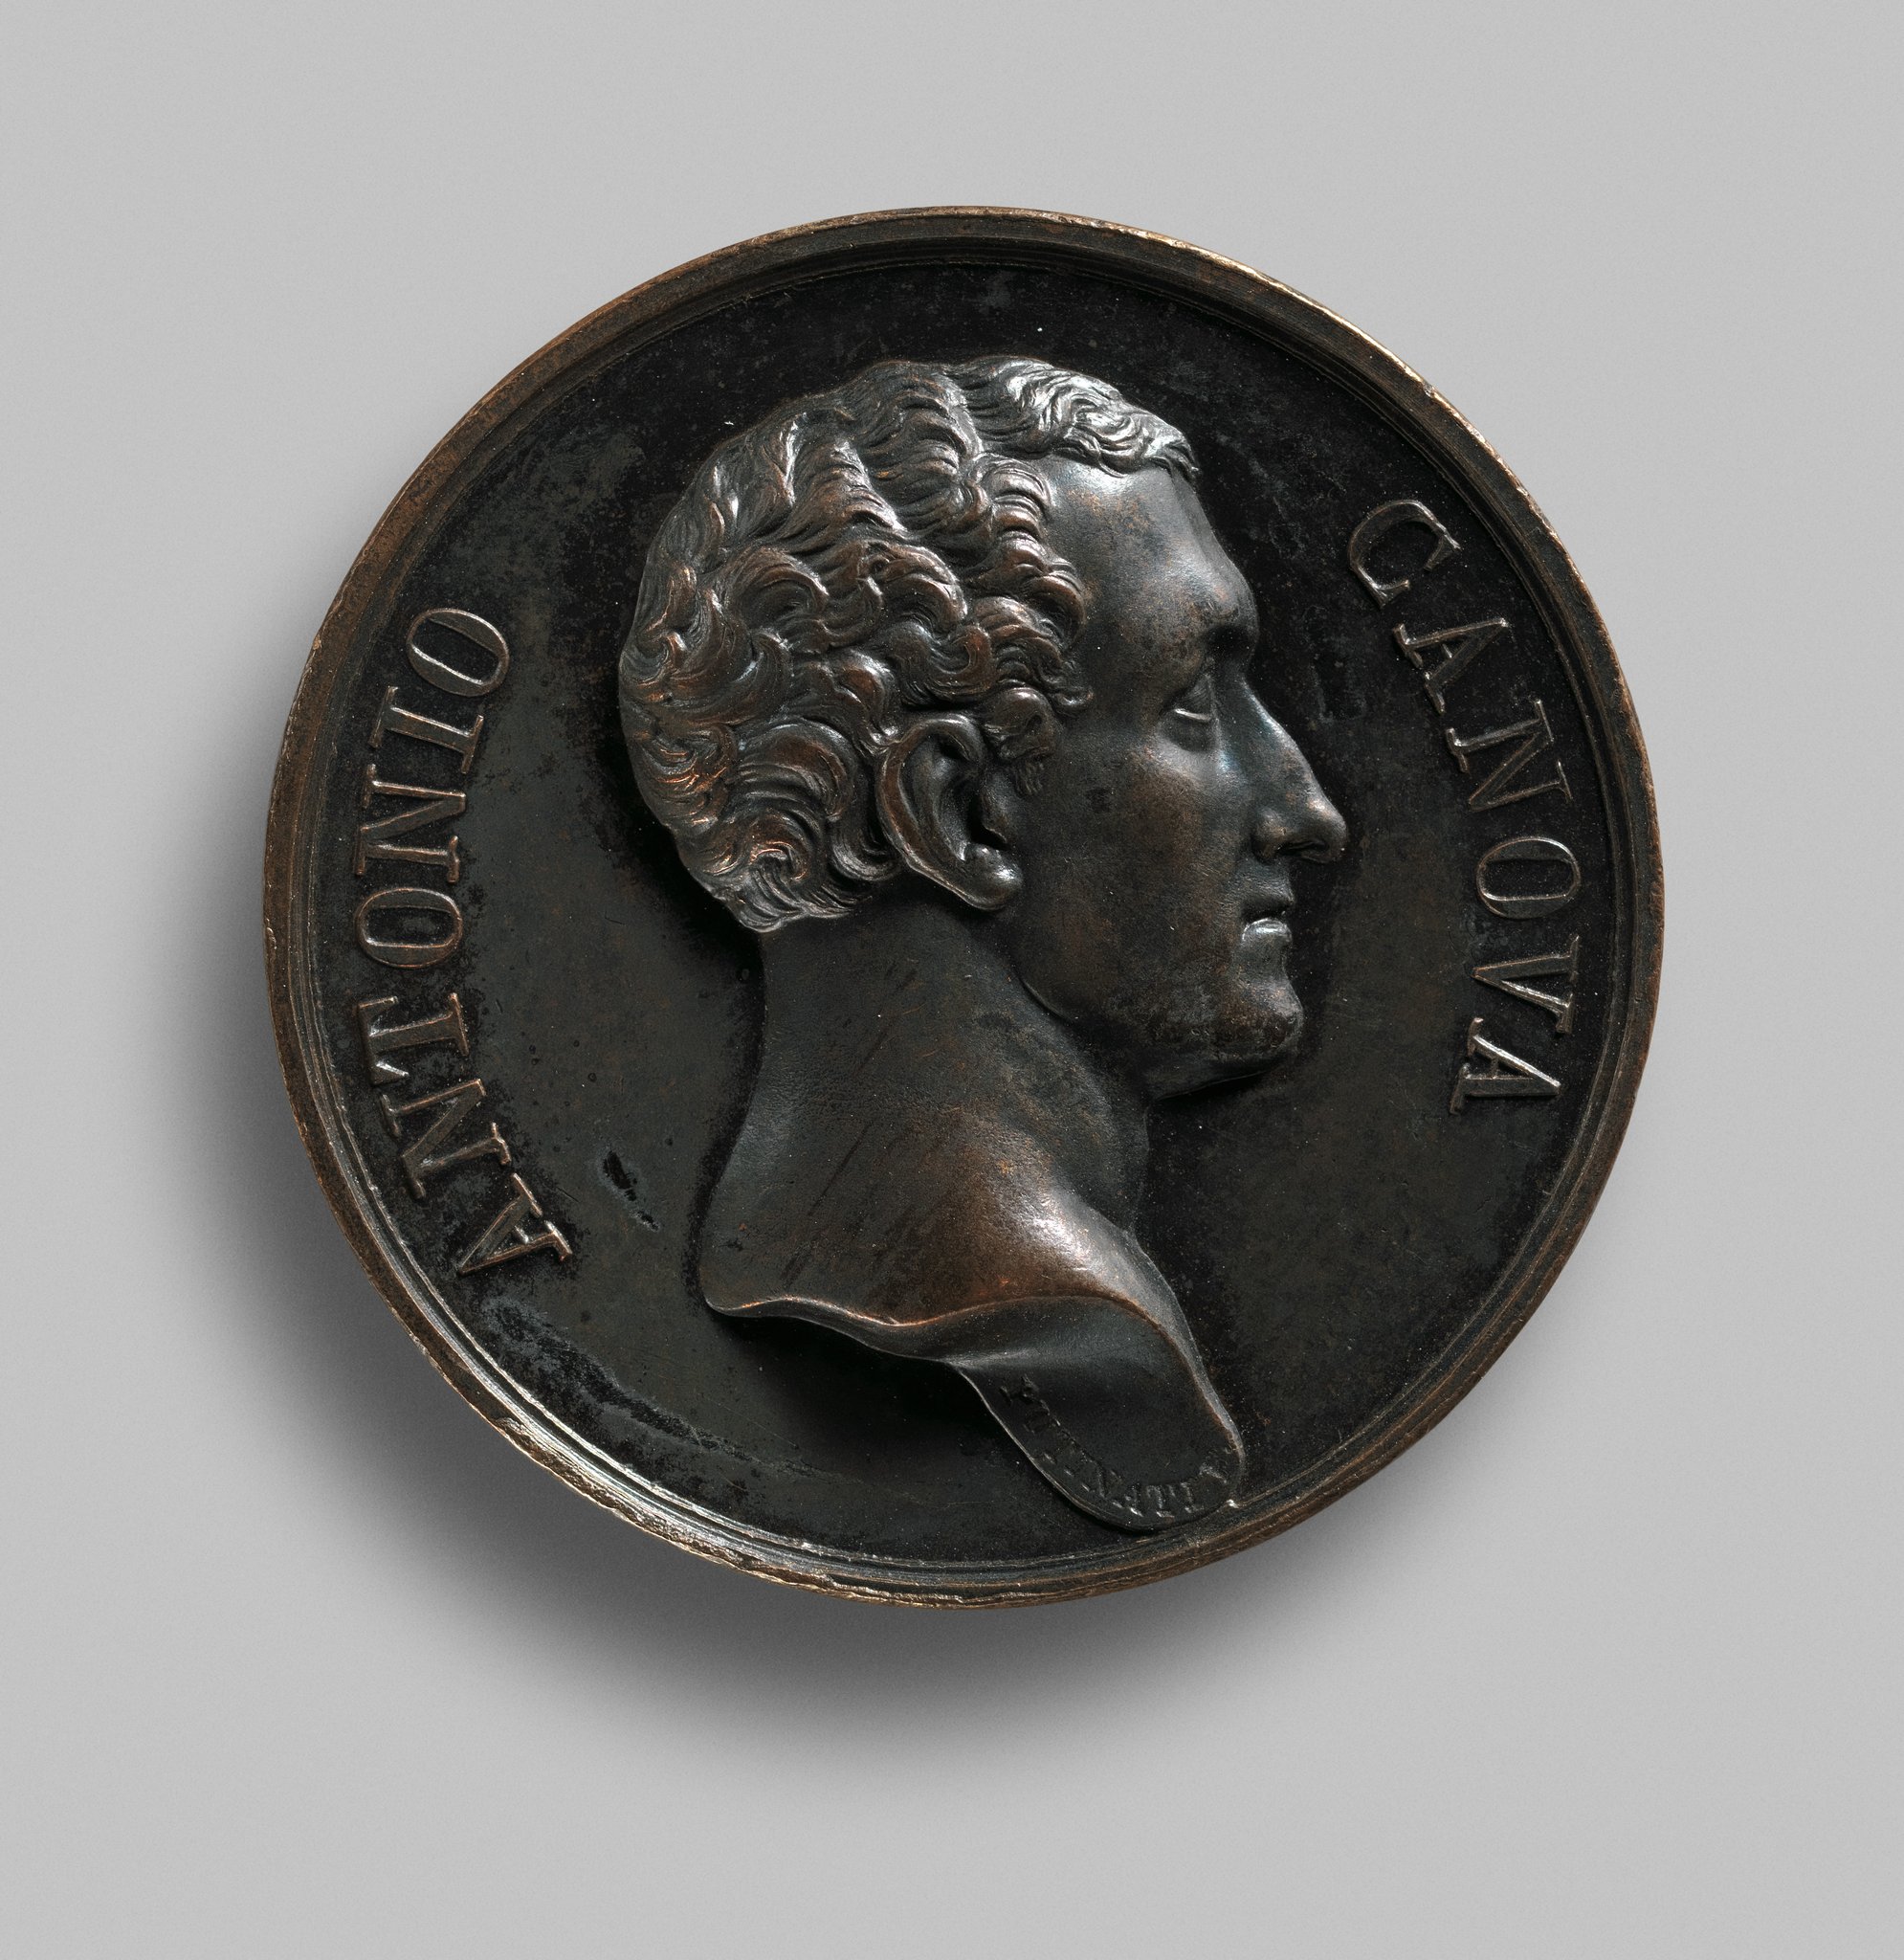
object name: medal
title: Portrait of Antonio Canova (1757–1822)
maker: francesco putinati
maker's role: artist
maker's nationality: italian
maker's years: 1770-1848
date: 1822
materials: bronze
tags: men,profiles